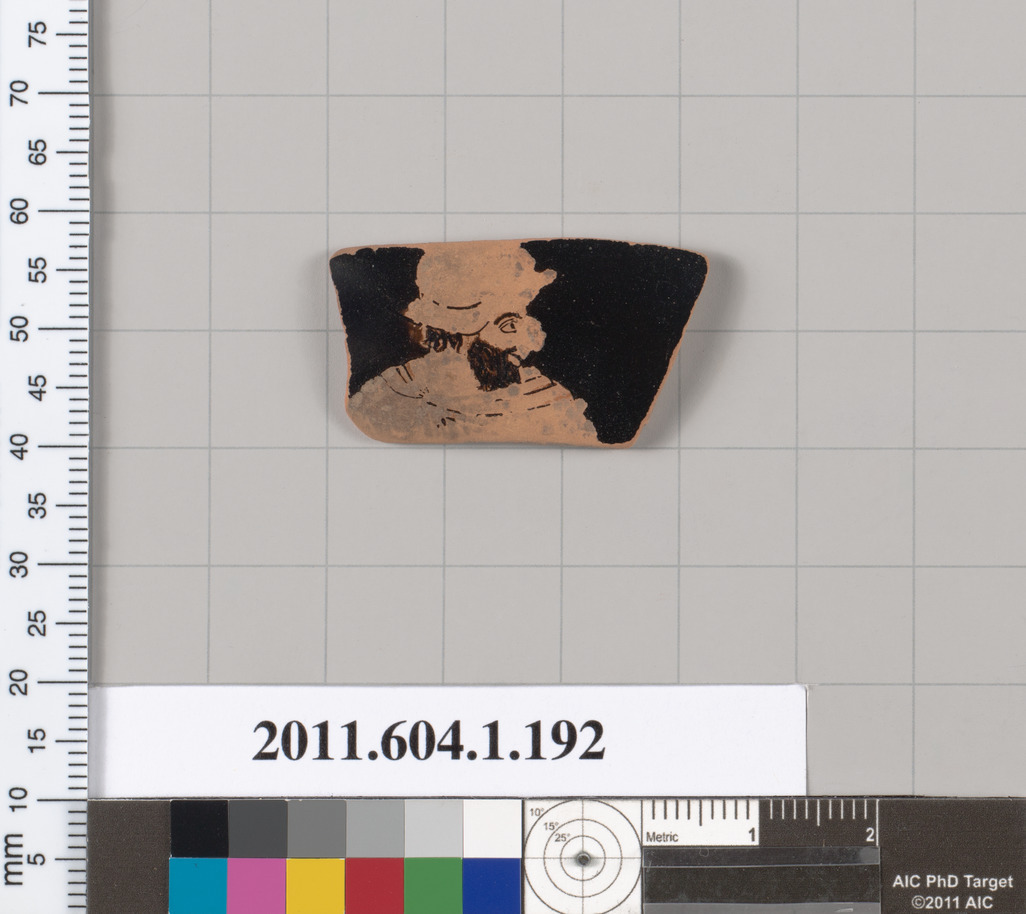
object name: kylix fragment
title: Terracotta fragment of a kylix (drinking cup)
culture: greek, attic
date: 475-451 BCE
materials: terracotta